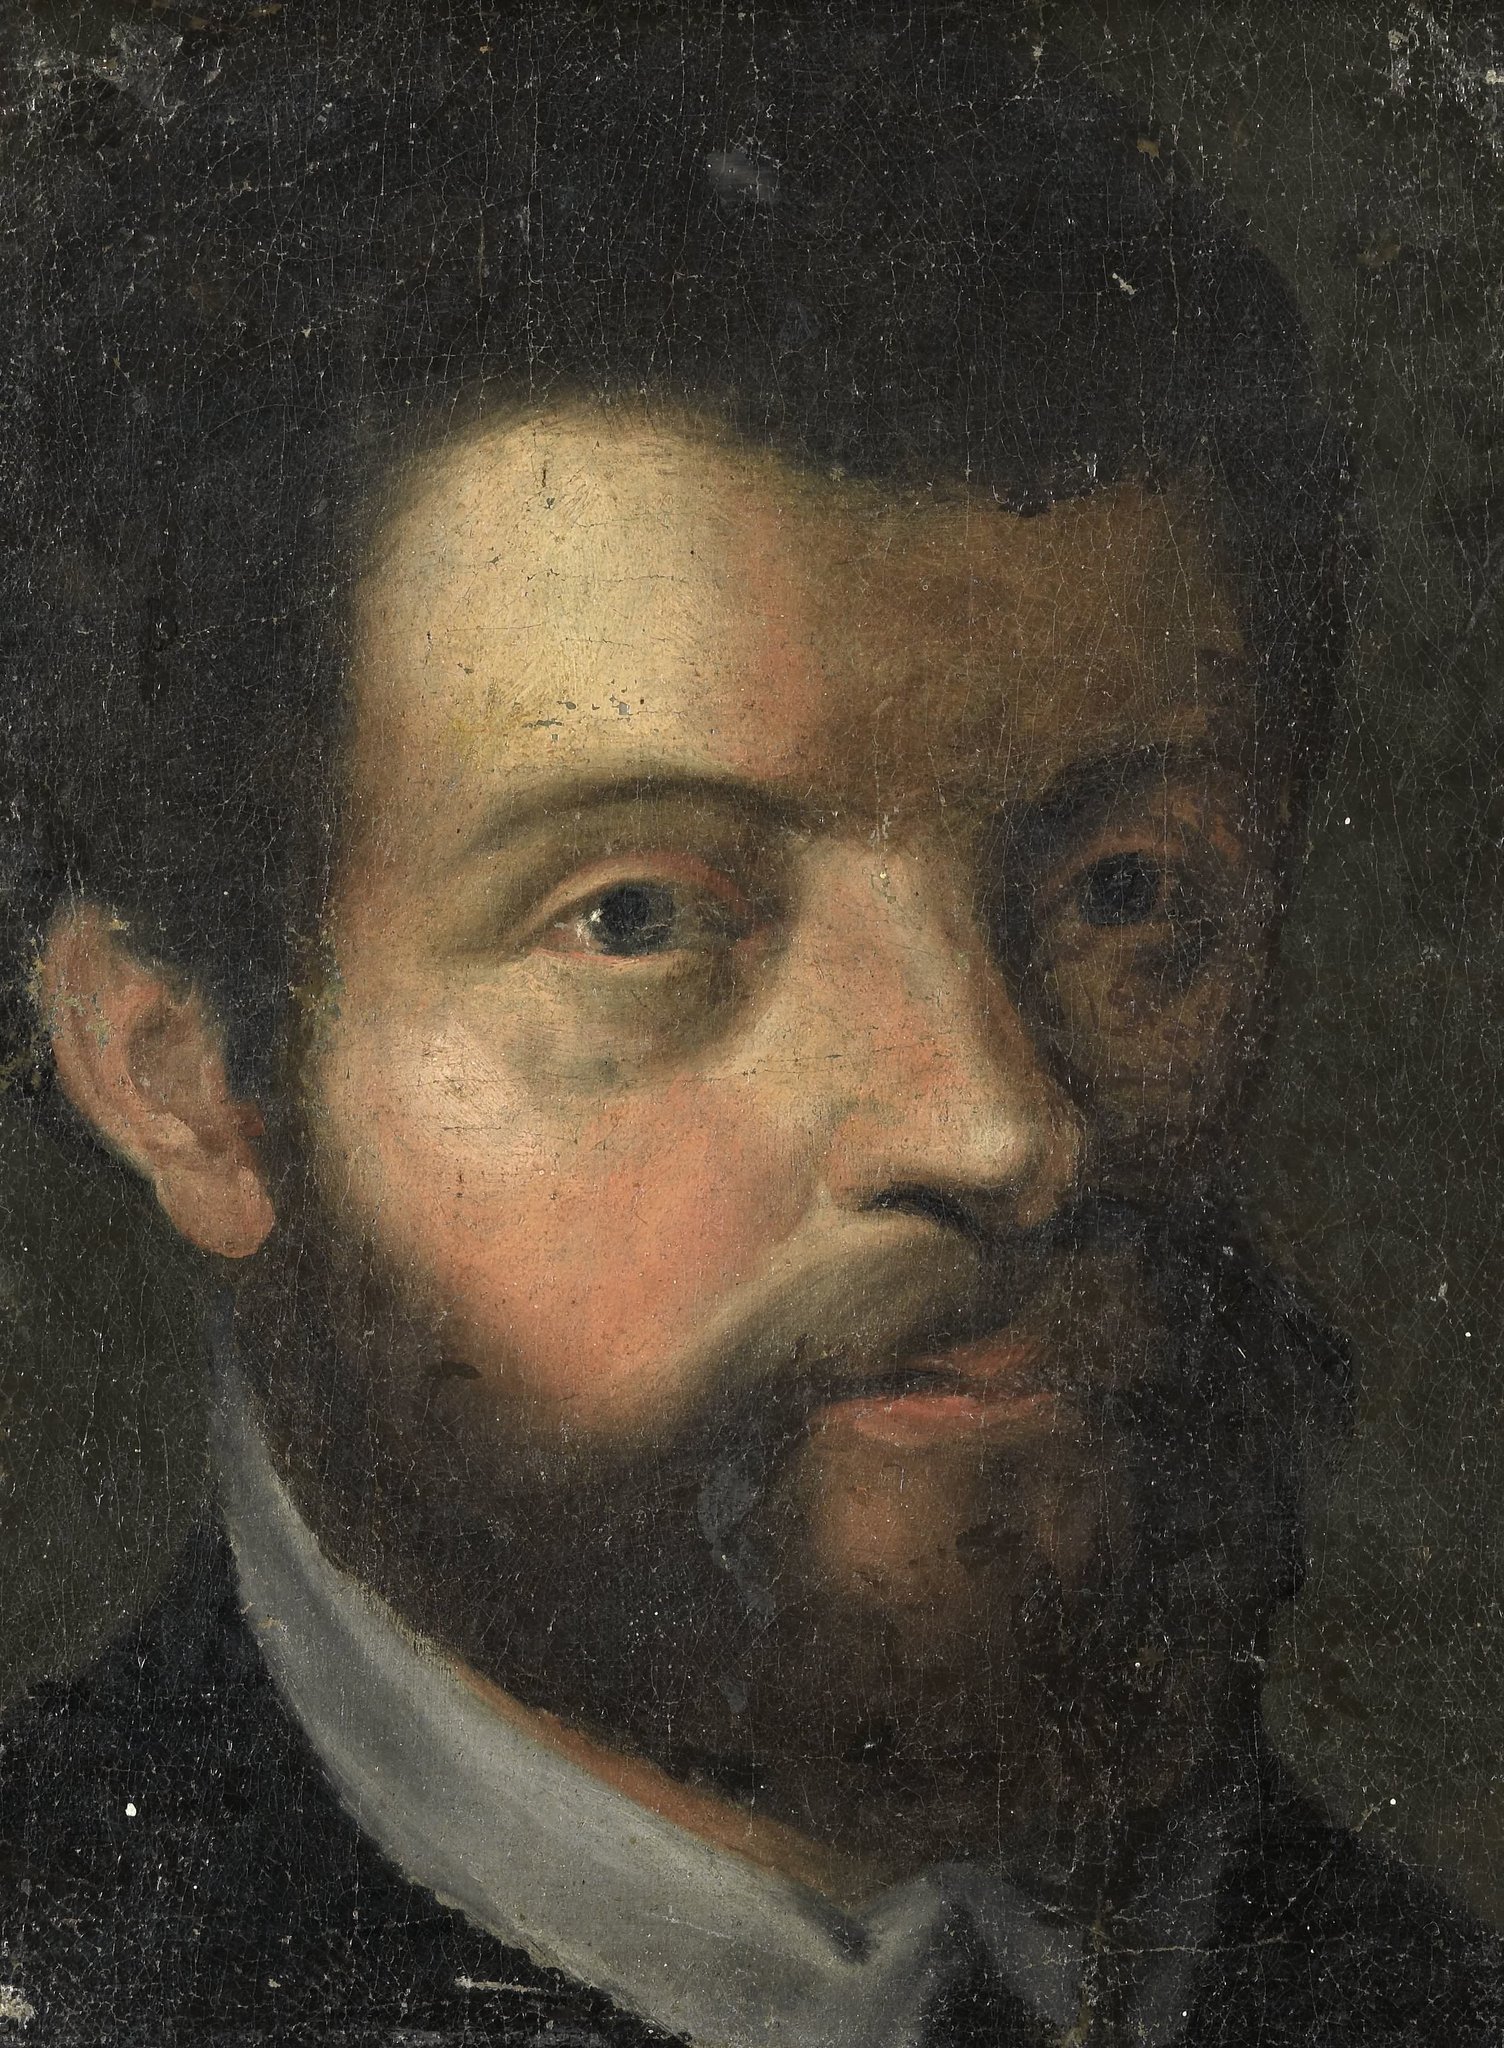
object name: painting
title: Portrait of a Man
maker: Anonymous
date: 1560-1799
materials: canvas, oil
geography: italy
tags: anonymous historical person portrayed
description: Portret van een man. Kop van een man met baard, driekwart naar rechts